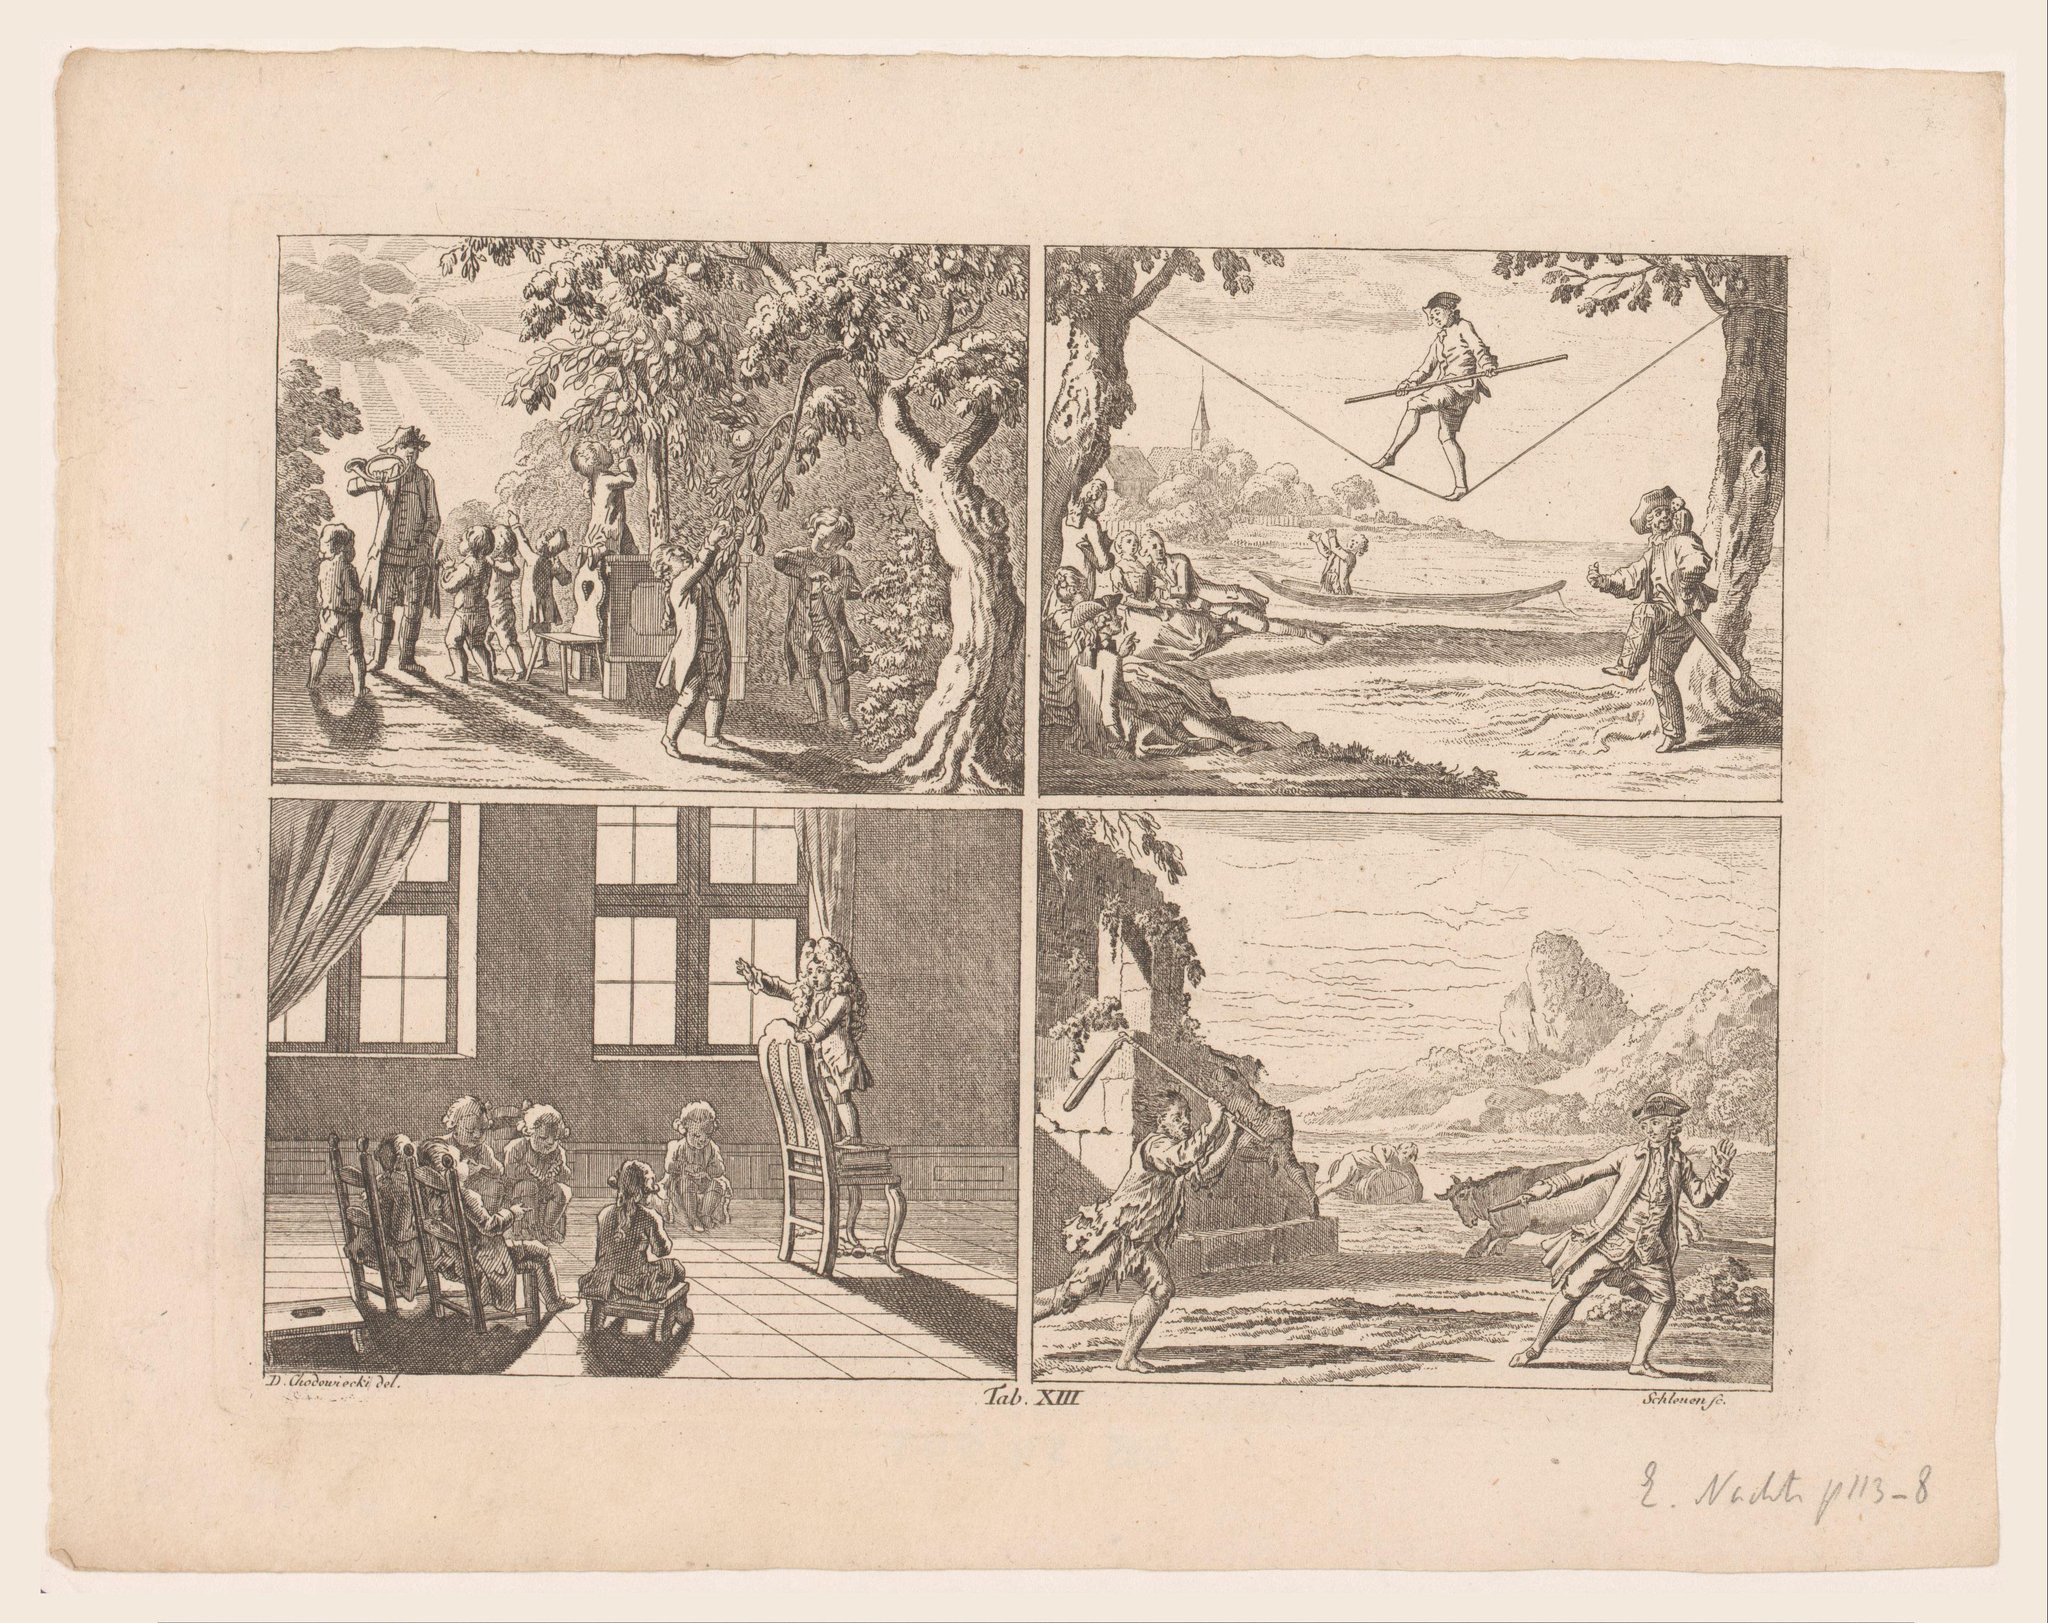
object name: print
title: Voedingsmiddelen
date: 1765-1806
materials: paper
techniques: etching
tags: housewife apportioning food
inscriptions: collector's mark: Lugt 2228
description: Prent ook gebruikt in: Allgemeine deutsche Bibliothek. Berlijn en Stettin: Friedrich Nicolai, 1765-1806.